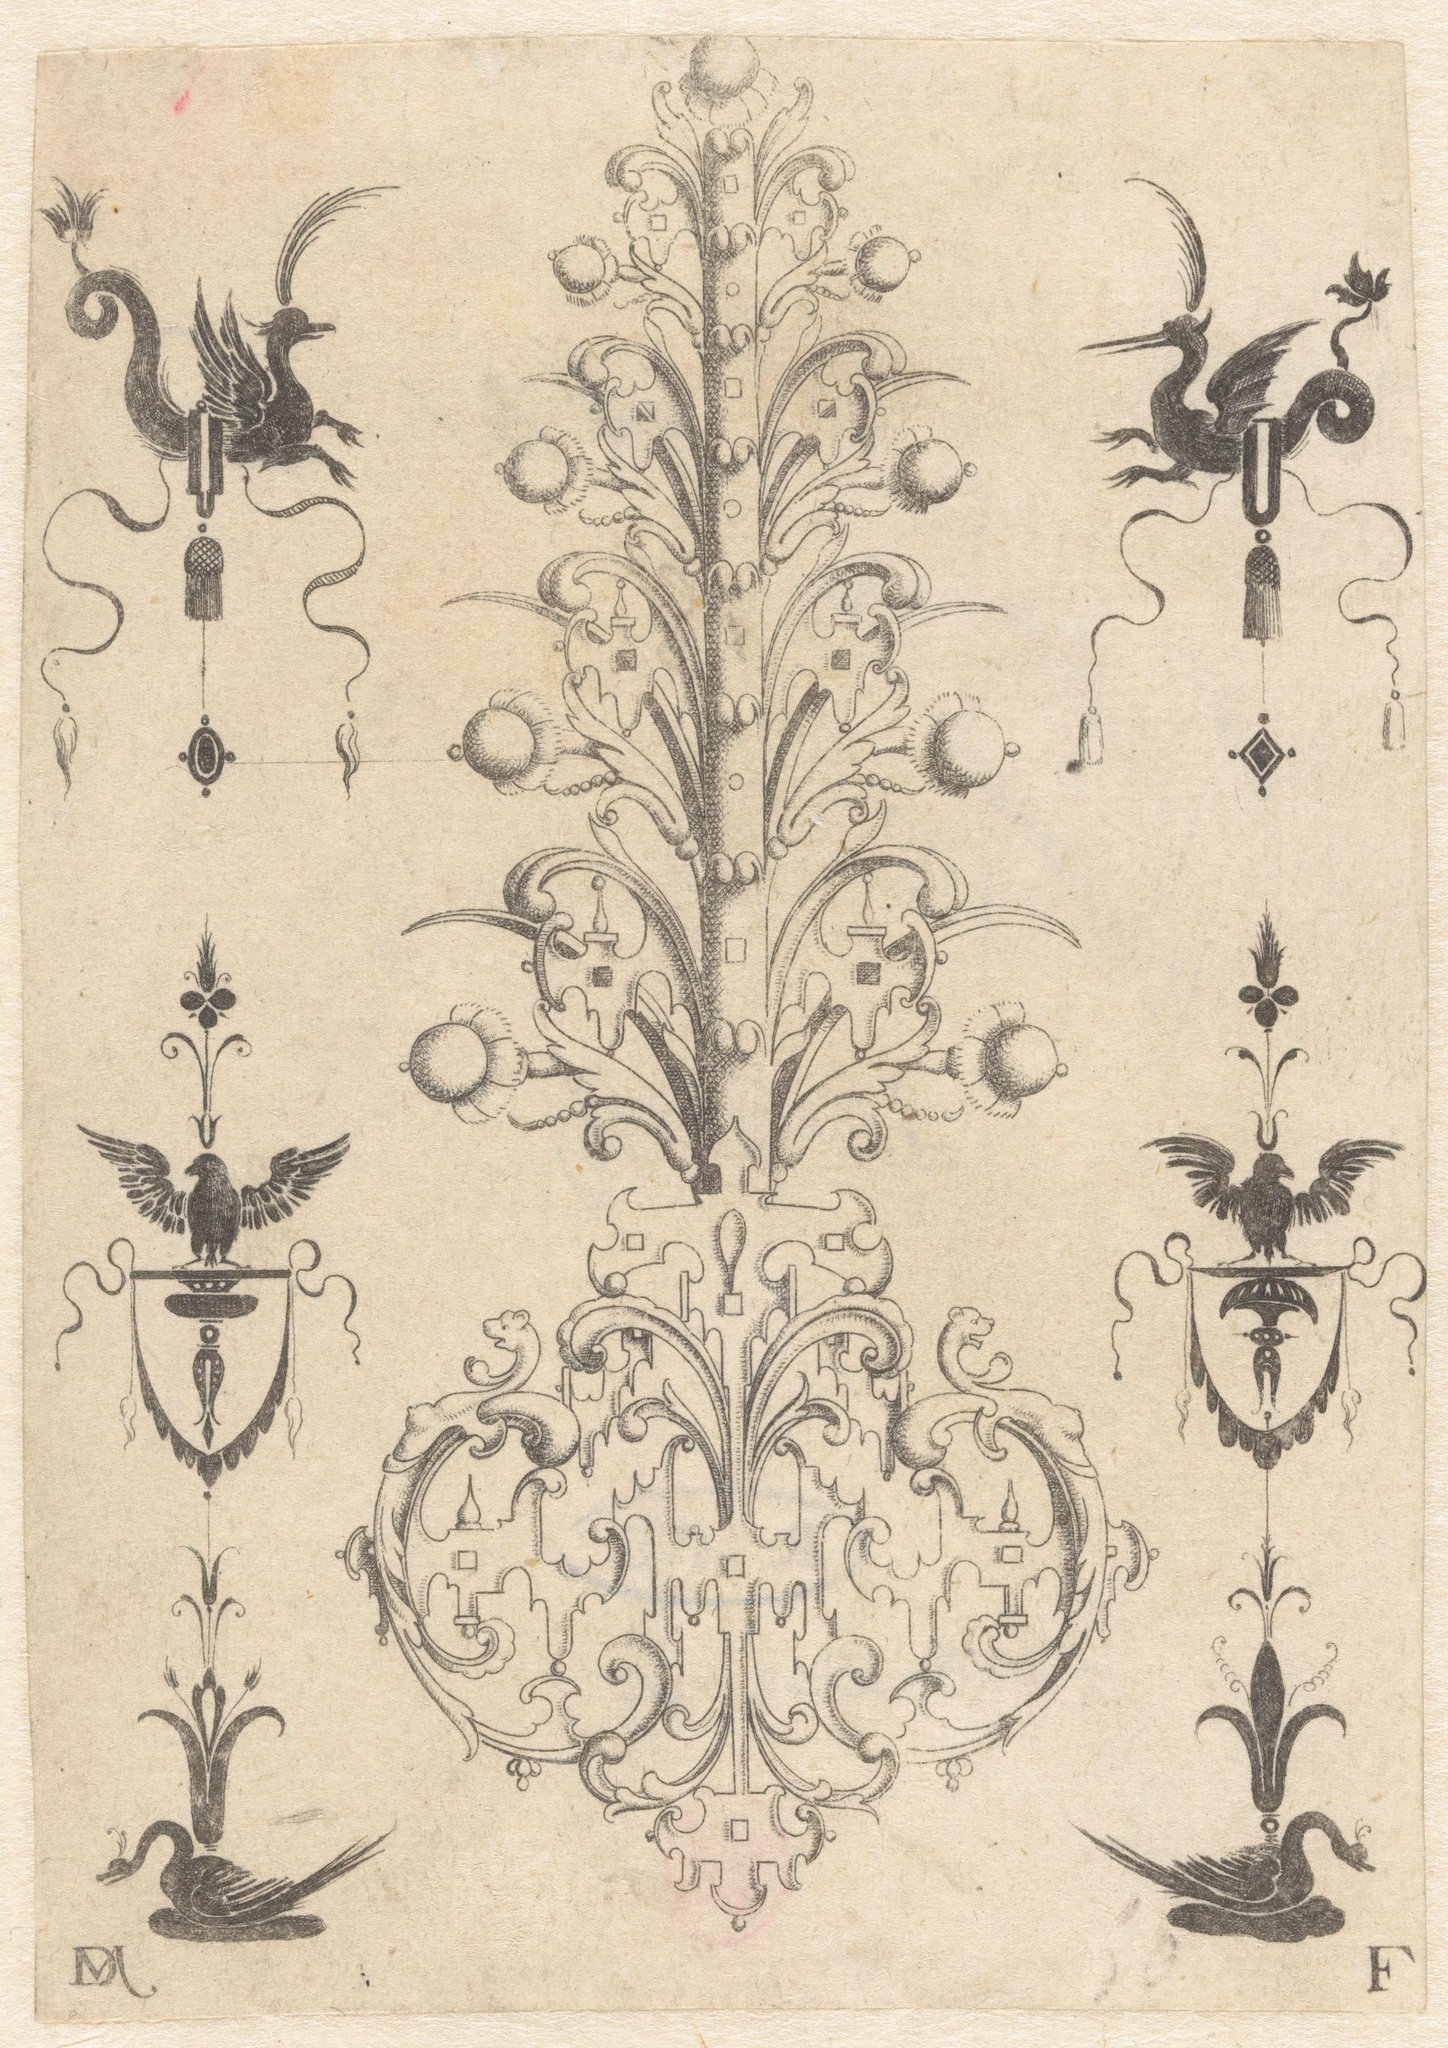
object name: print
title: Grote broche in de vorm van een hyacint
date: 1593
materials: paper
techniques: engraving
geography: augsburg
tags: ornaments ~ art, predatory birds: eagle, water-birds: swan, brooch, agraffe, clasp, fabulous beings with wings, flowers: hyacinth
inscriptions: collector's mark: Lugt 2760, collector's mark: Lugt 4171, signature: ‘DM F’, collector's mark: Lugt 2228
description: Ontwerp voor een broche in de vorm van een hyacint. Bovenaan zijn twee gevleugelde fabeldieren te zien, in het midden zijn twee adelaars op voetstukken geplaatst en onderaan zijn twee zwanen geplaatst.